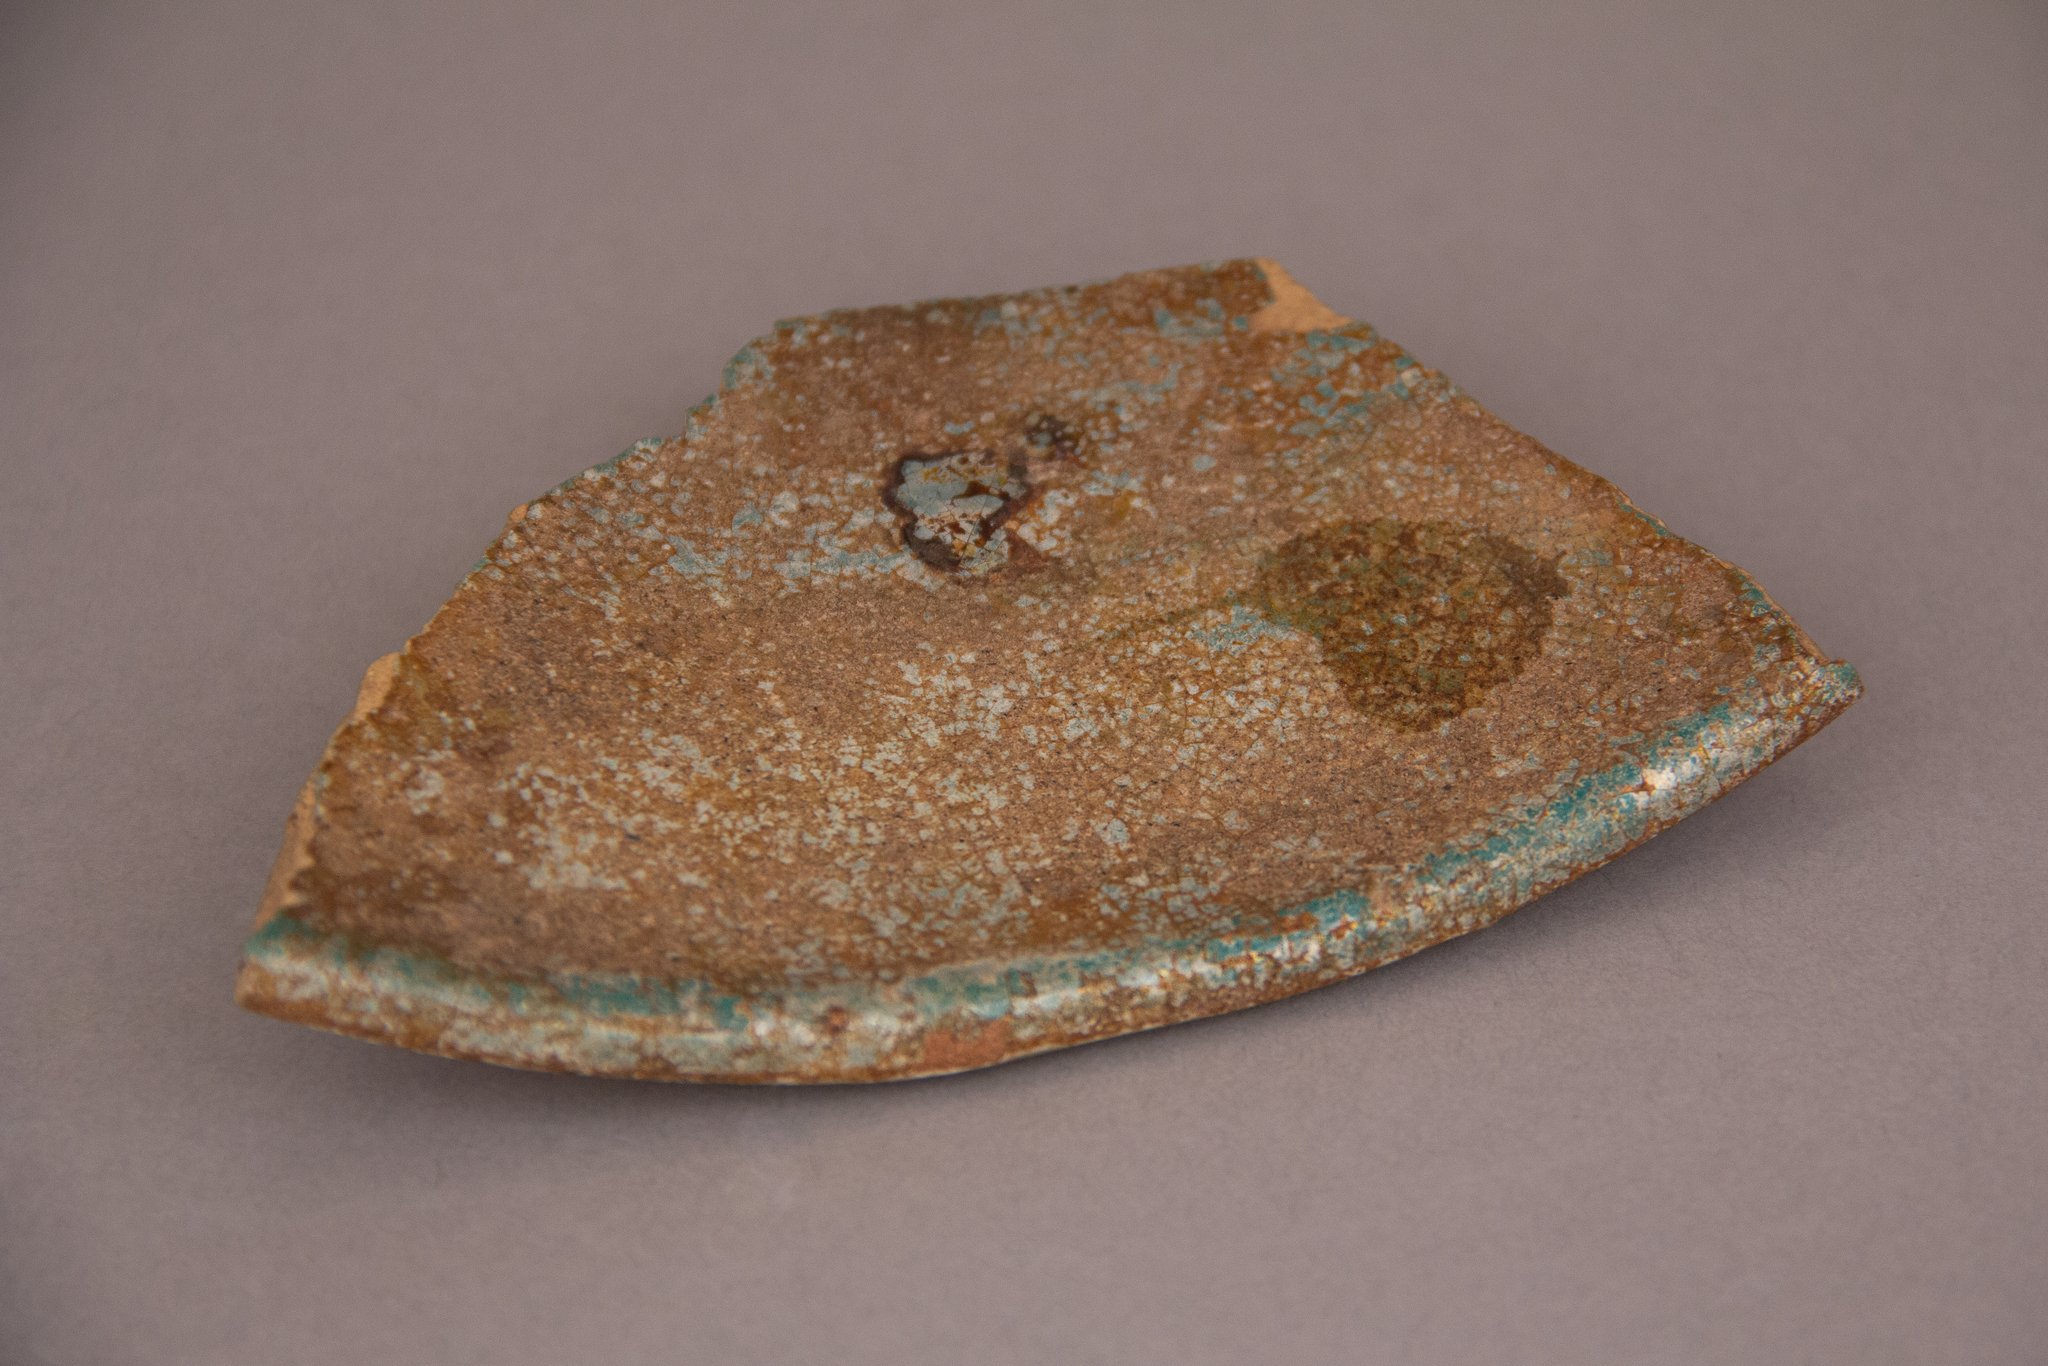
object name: waster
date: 901-1000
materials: earthenware, glaze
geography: iran